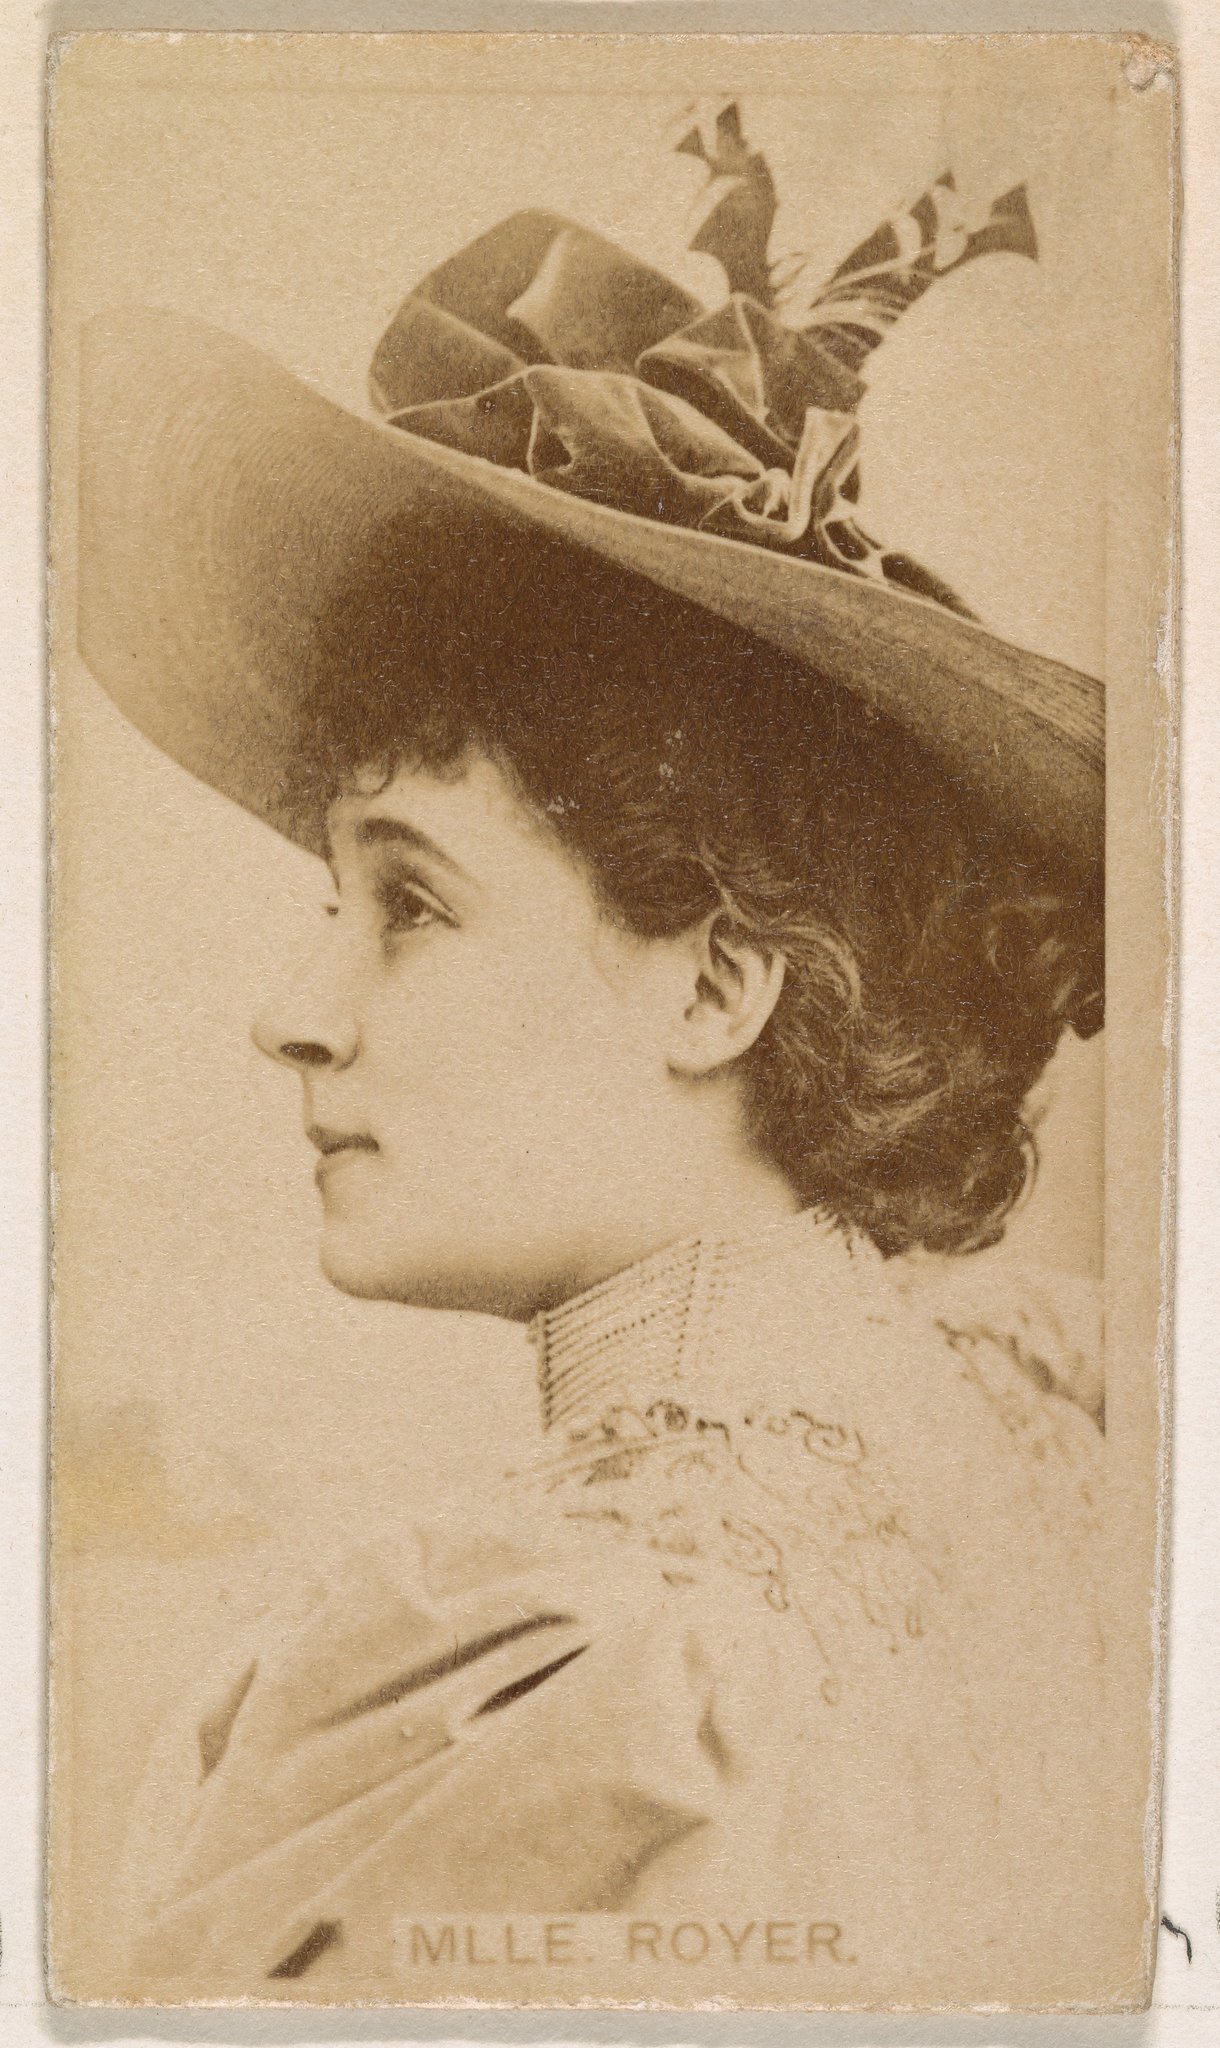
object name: photograph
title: Mlle. Royer, from the Actresses series (N245) issued by Kinney Brothers to promote Sweet Caporal Cigarettes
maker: kinney brothers tobacco company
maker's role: publisher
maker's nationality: american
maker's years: 1869-2011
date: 1890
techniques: albumen silver print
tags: women,actresses